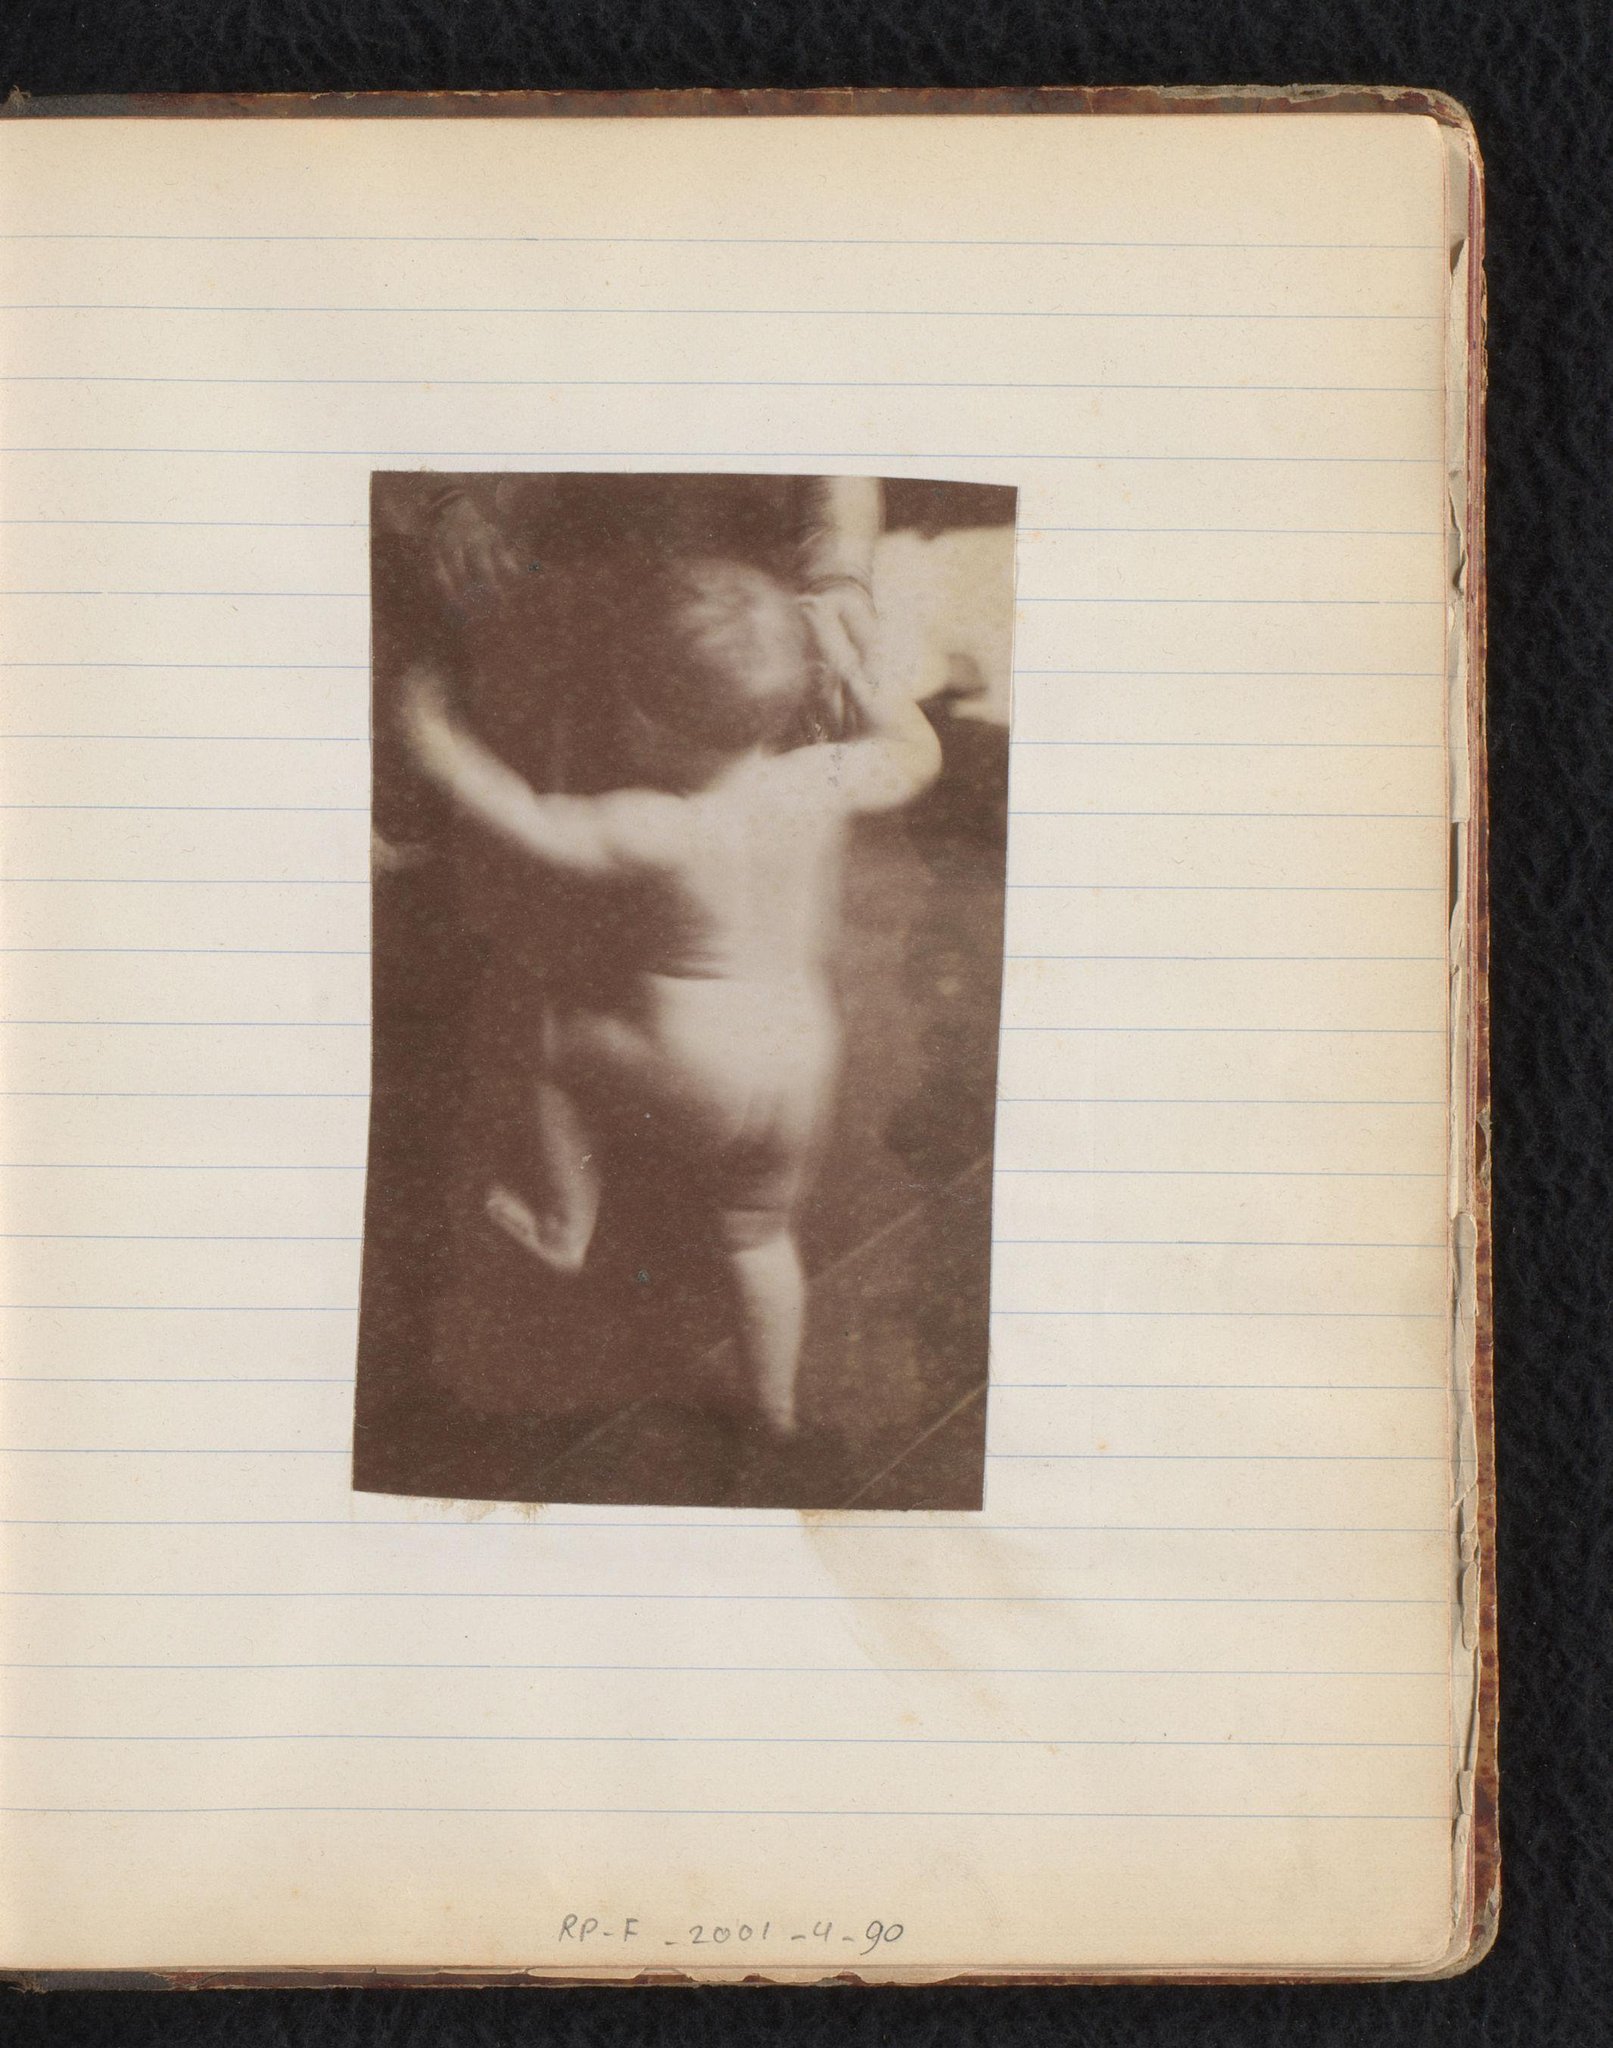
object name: album leaf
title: Studie van een naakte peuter en vrouw, door Jacques de Lalaing, voorstudie voor Heilige Maagd met het kind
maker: jacques lalaing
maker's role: painter, sculptor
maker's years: 1858-1917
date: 1900-1914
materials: photographic support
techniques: albumen print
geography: brussels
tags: infant, baby, artist (in general) working from nude model, the (nude) human figure; 'corpo humano' (ripa) (+ back view)